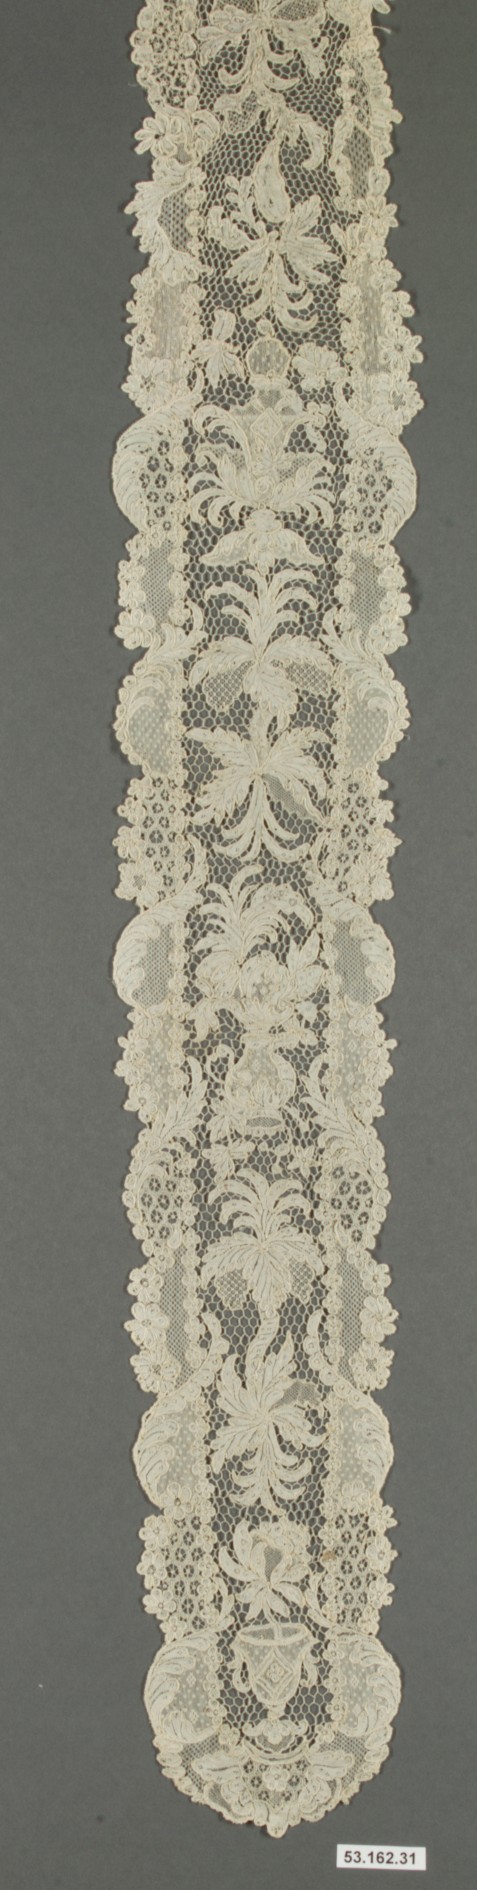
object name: lappet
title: Pair of joined lappets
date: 1701-1800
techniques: lace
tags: flowers